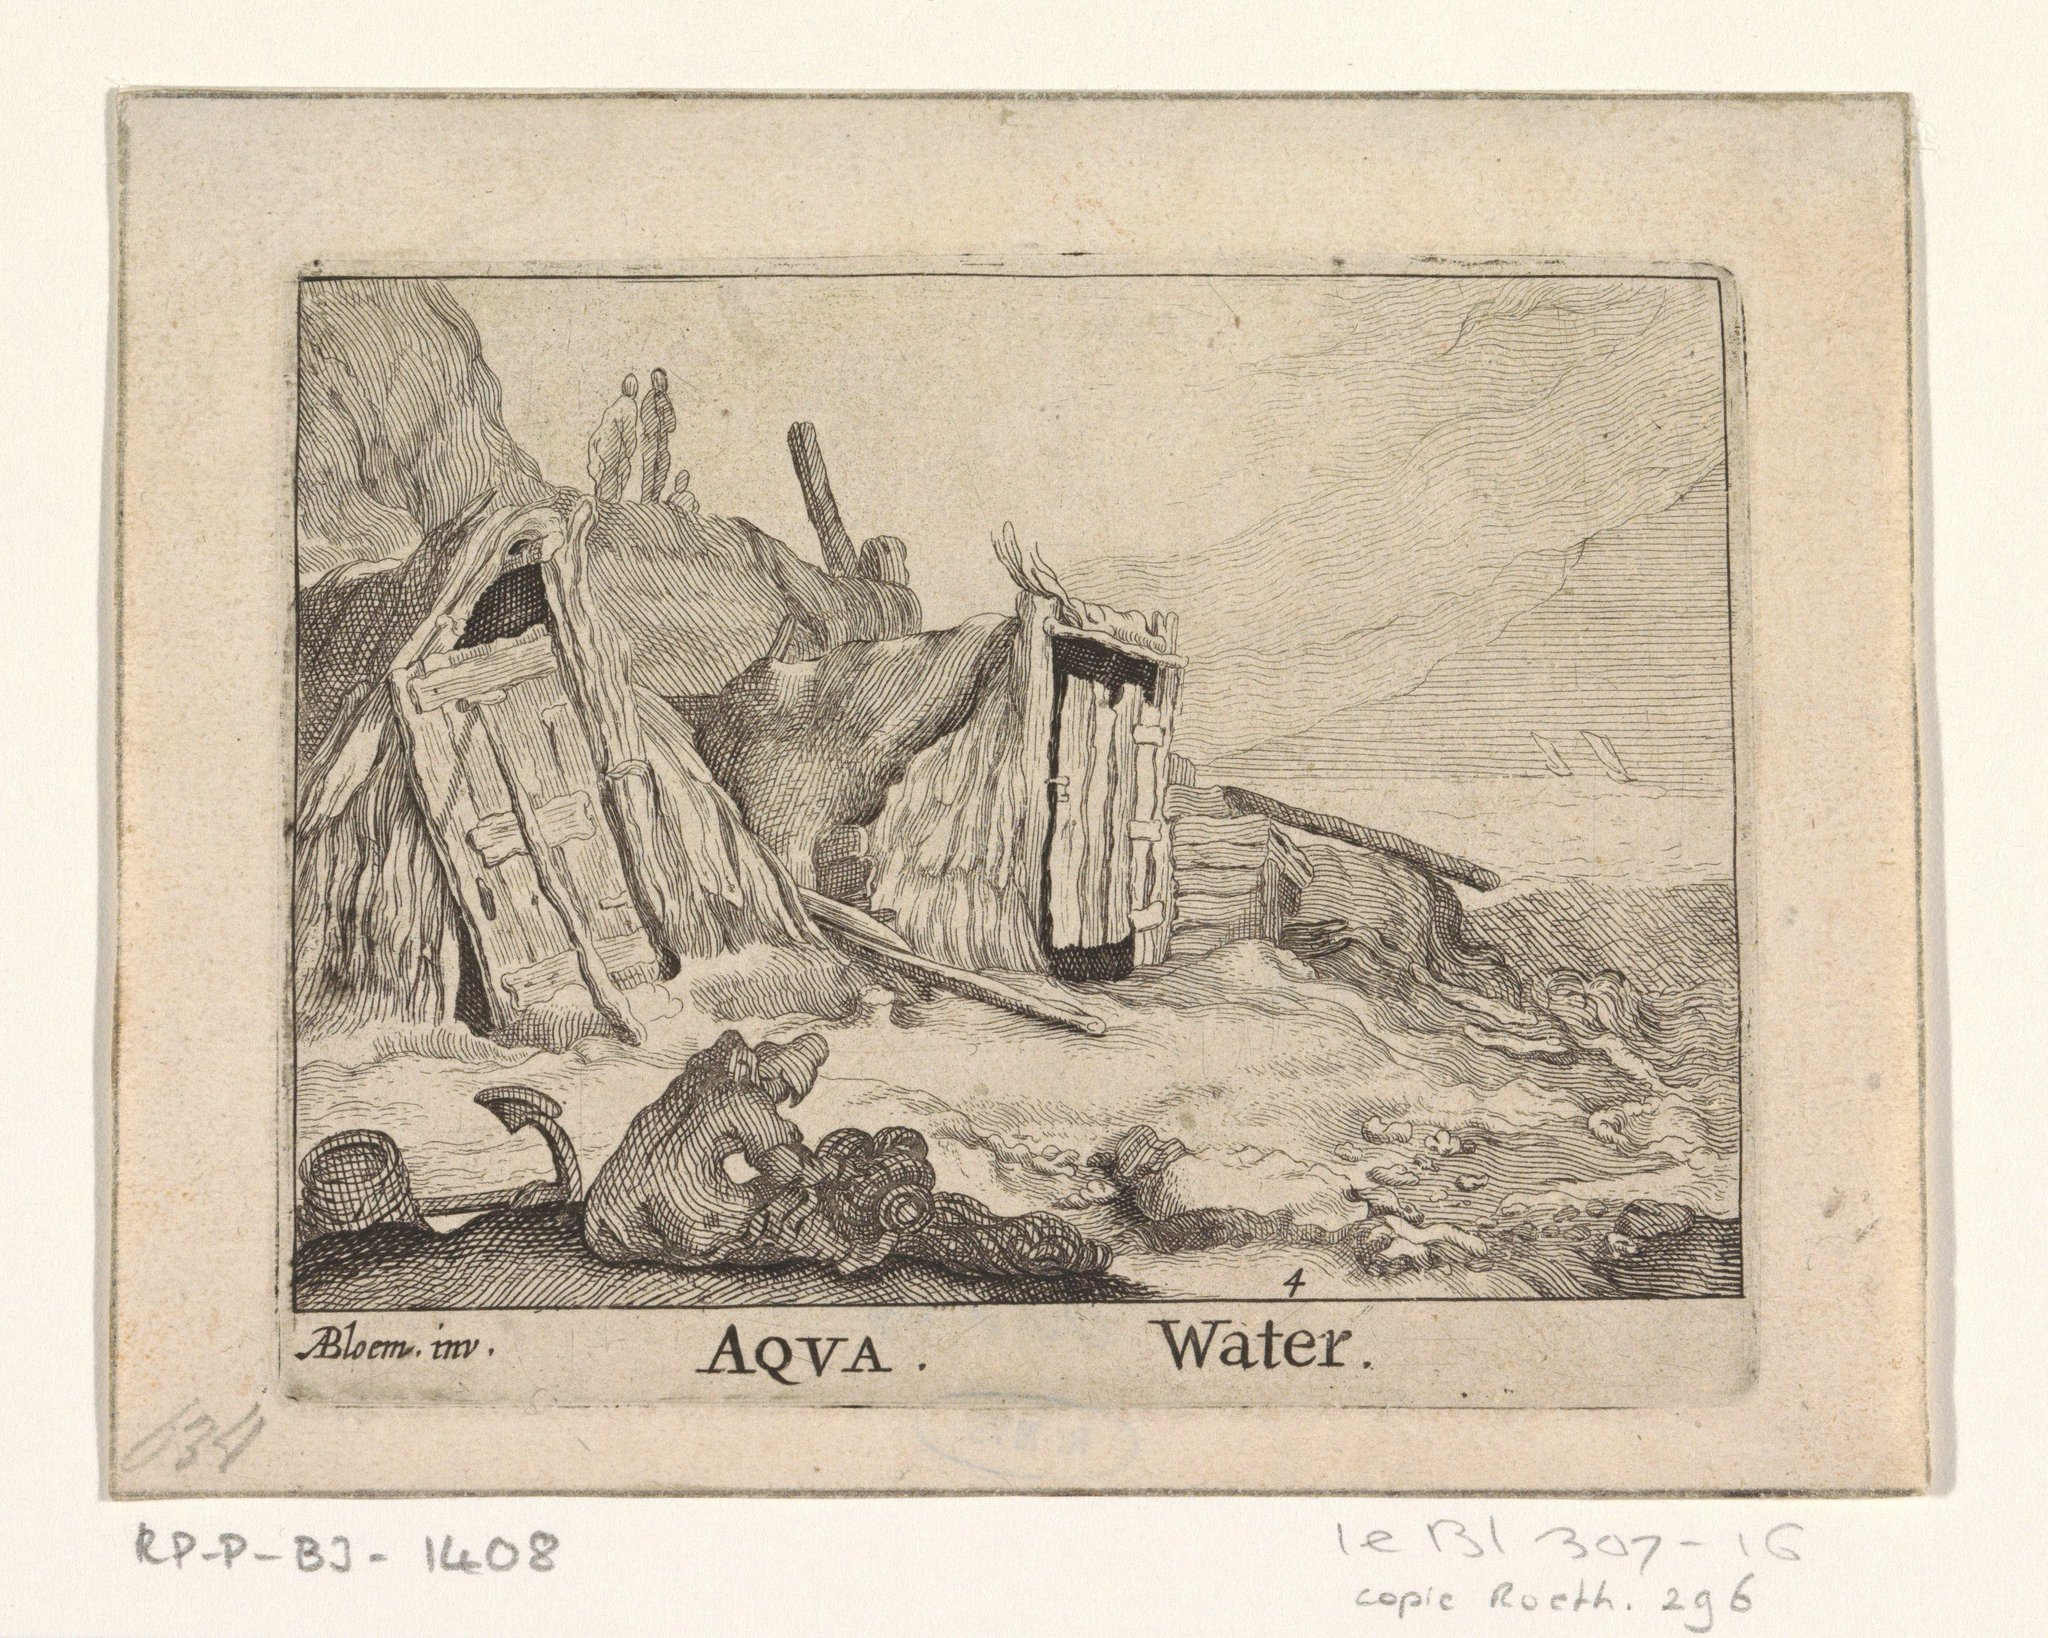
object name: print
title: Water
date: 1643-1679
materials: paper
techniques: engraving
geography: amsterdam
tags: water (one of the four elements)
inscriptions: collector's mark: Lugt 2228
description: Bouwvallige vissershutjes staan aan de rand van de zee. Op de voorgrond zit een visser een net te knopen.